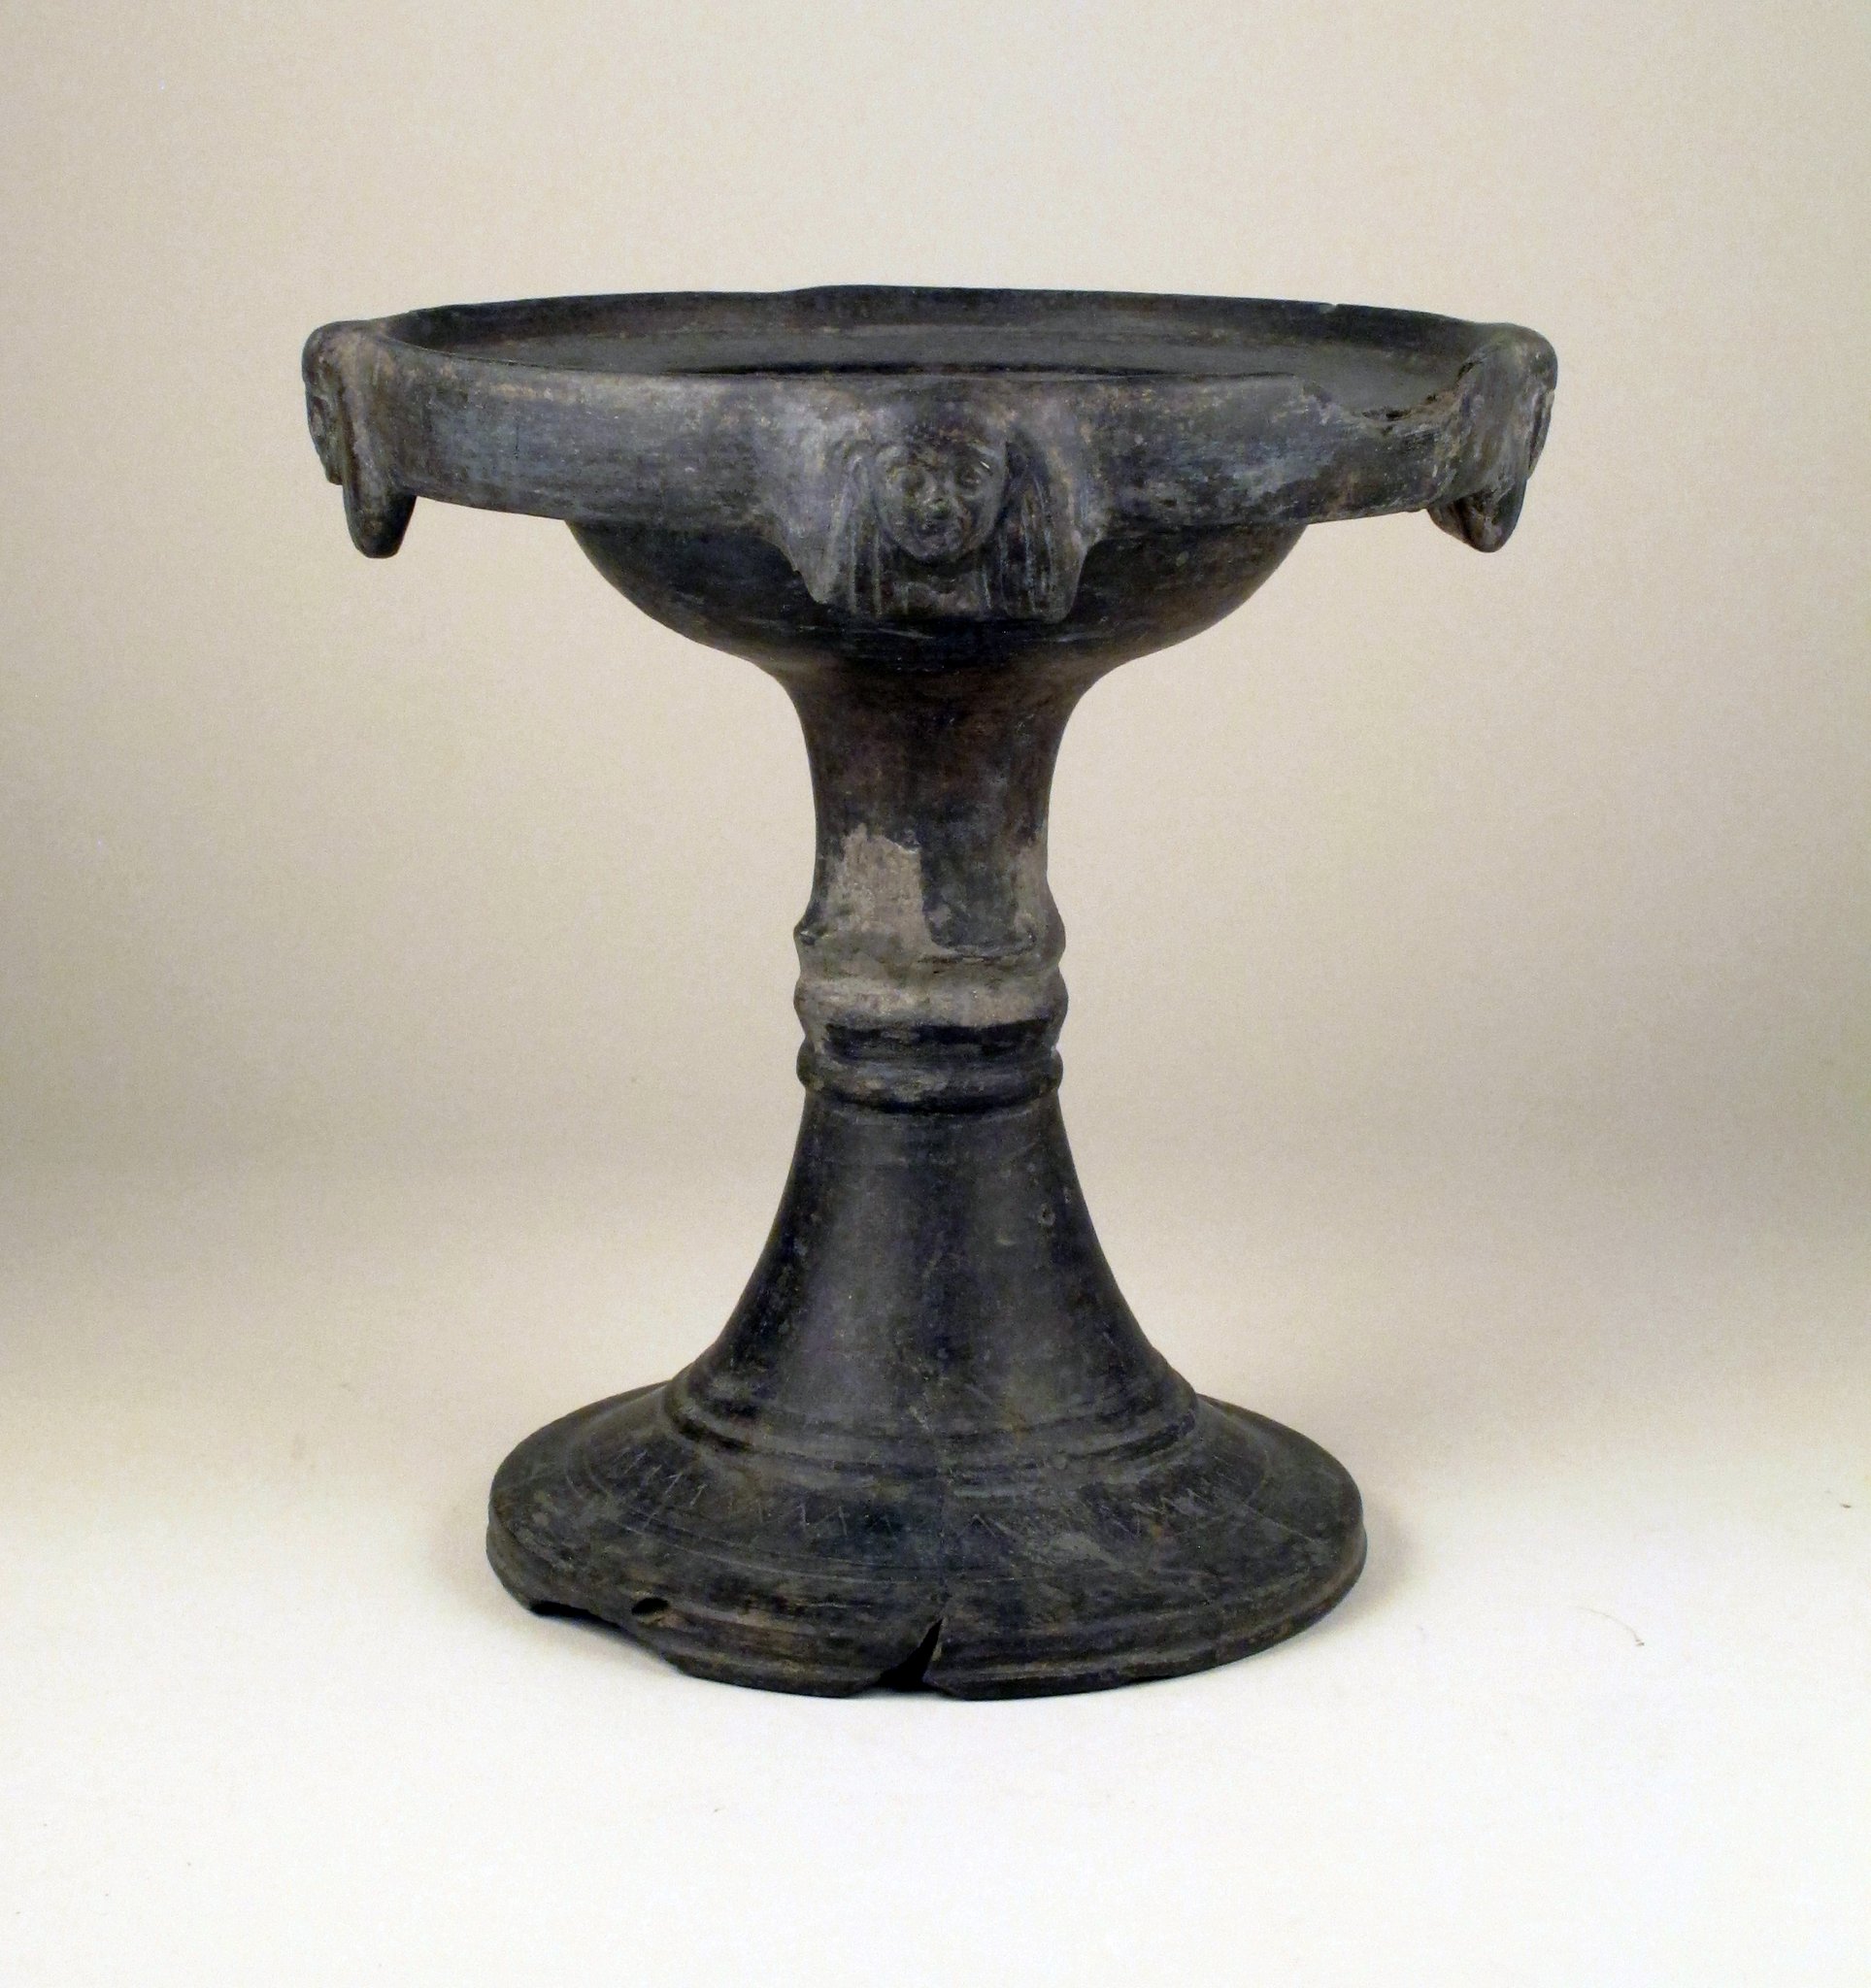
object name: dish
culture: etruscan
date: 570-500 BCE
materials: terracotta